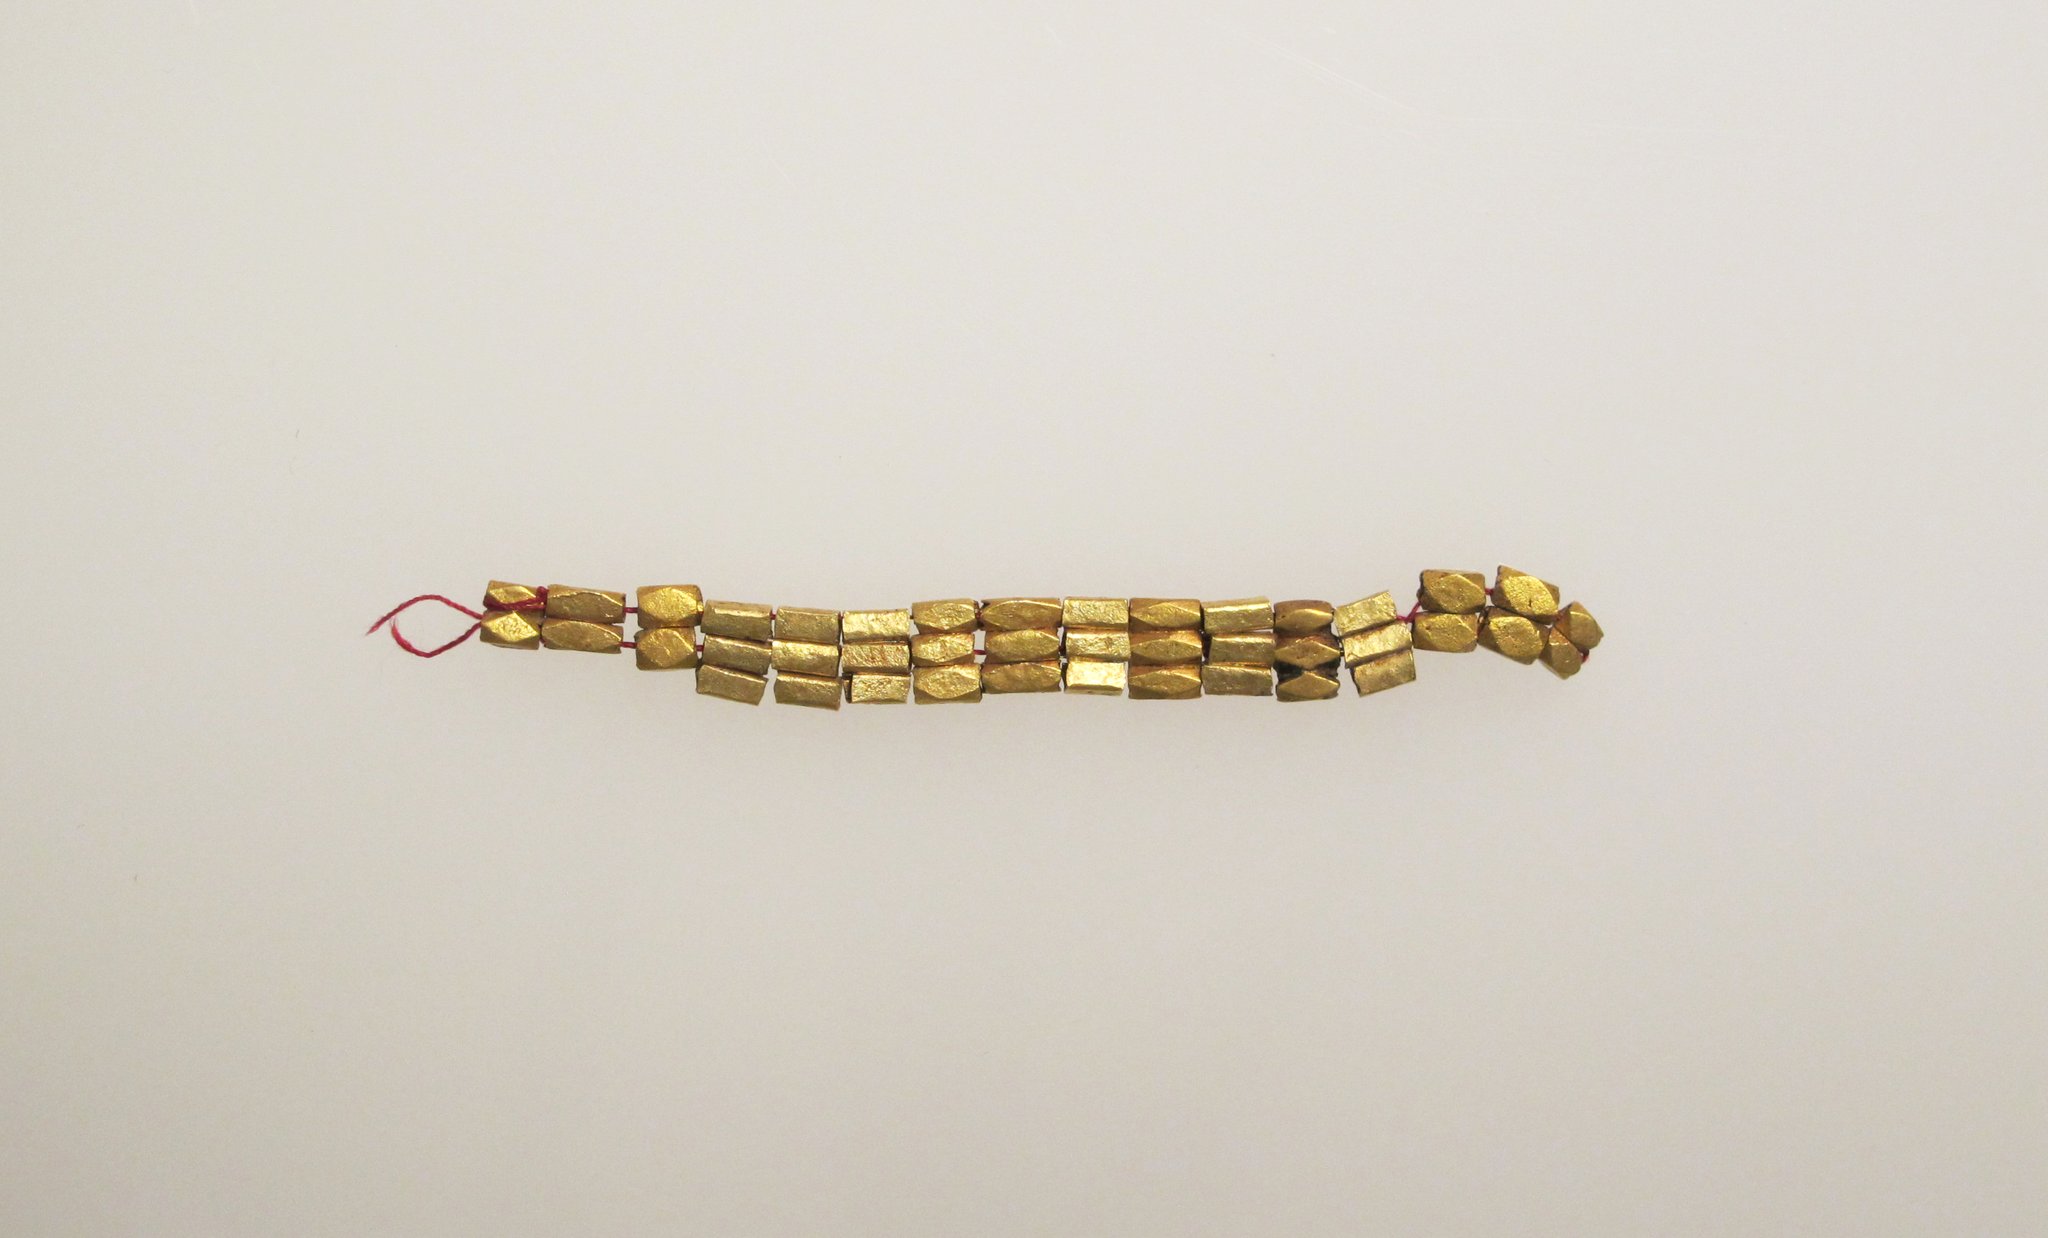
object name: necklace with 16 bead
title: Necklace with 16 beads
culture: roman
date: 201-300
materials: gold